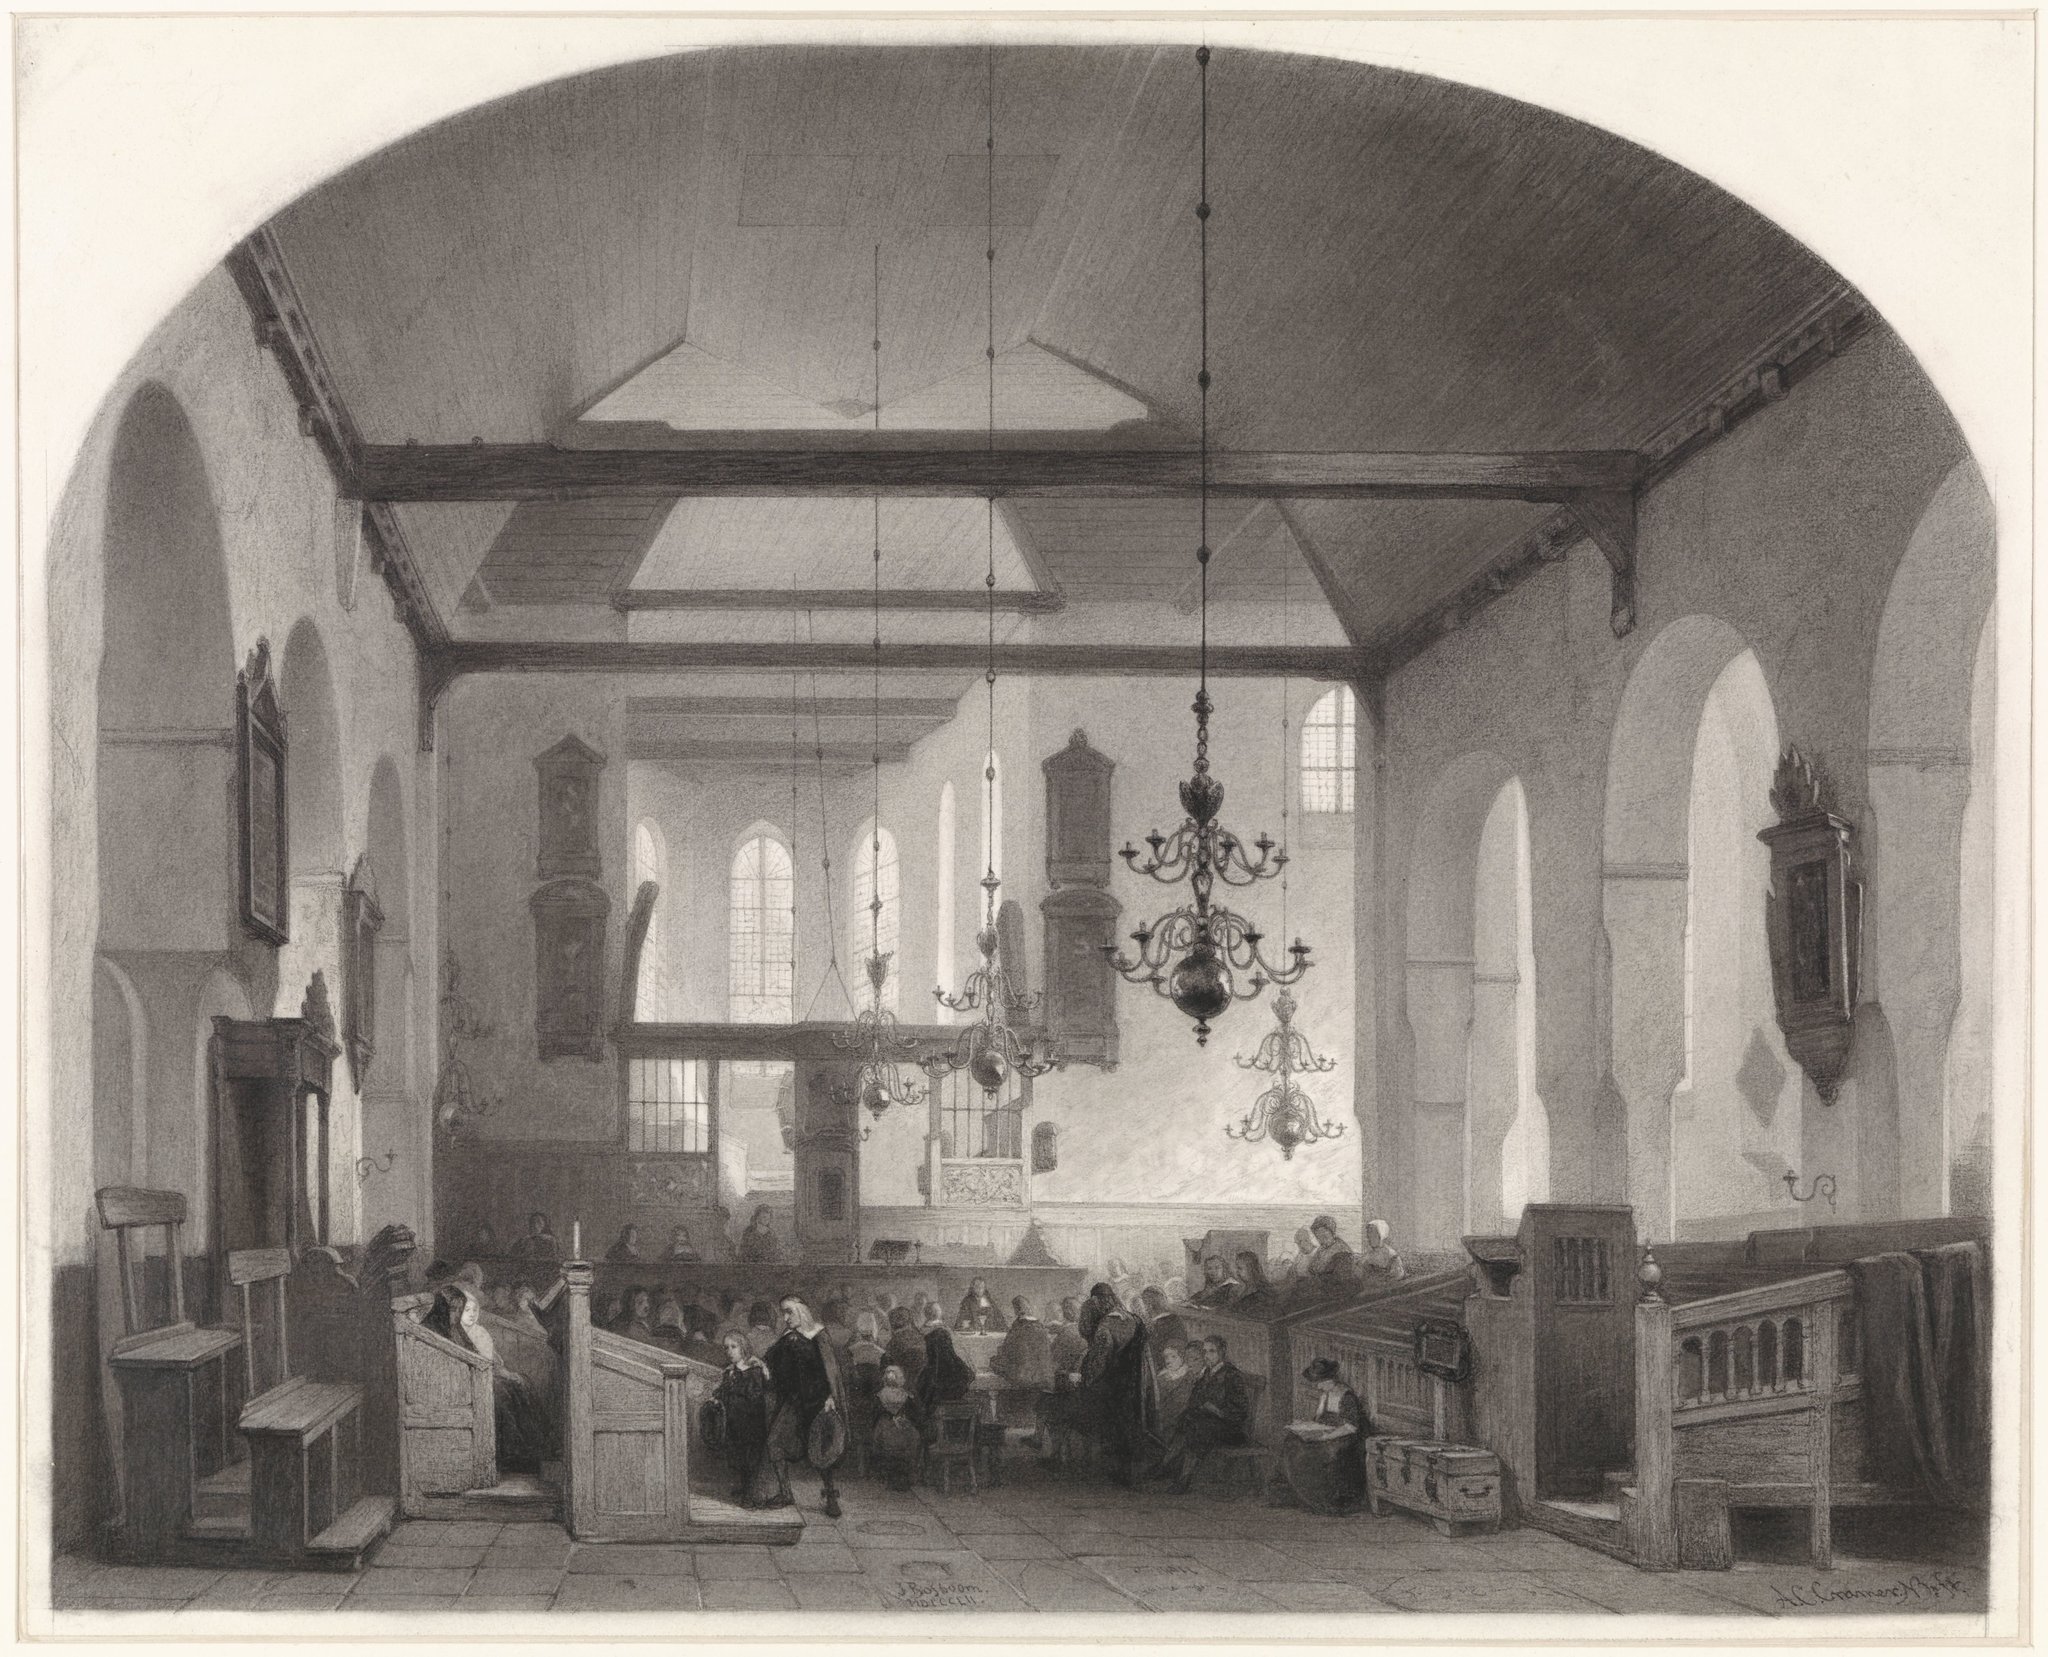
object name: drawing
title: Kerkinterieur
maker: anthony cornelis cramer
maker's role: draughtsman, painter, print maker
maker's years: 1842-1914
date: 1852-1914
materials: chalk, paper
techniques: scratching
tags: interior of church, protestant service